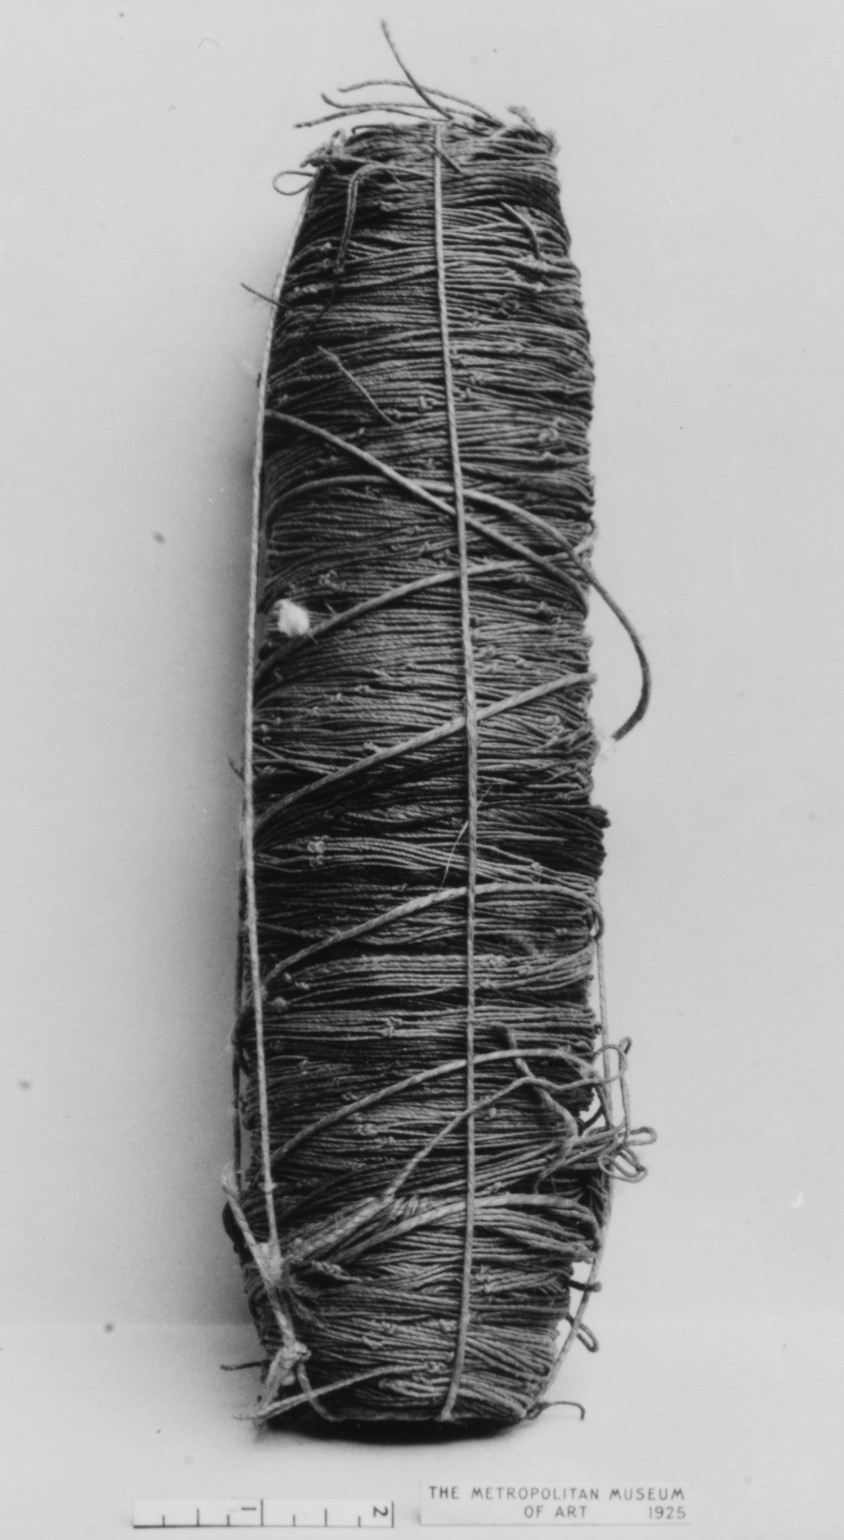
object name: fish net, on roll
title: Fish Net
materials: cord, linen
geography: egypt